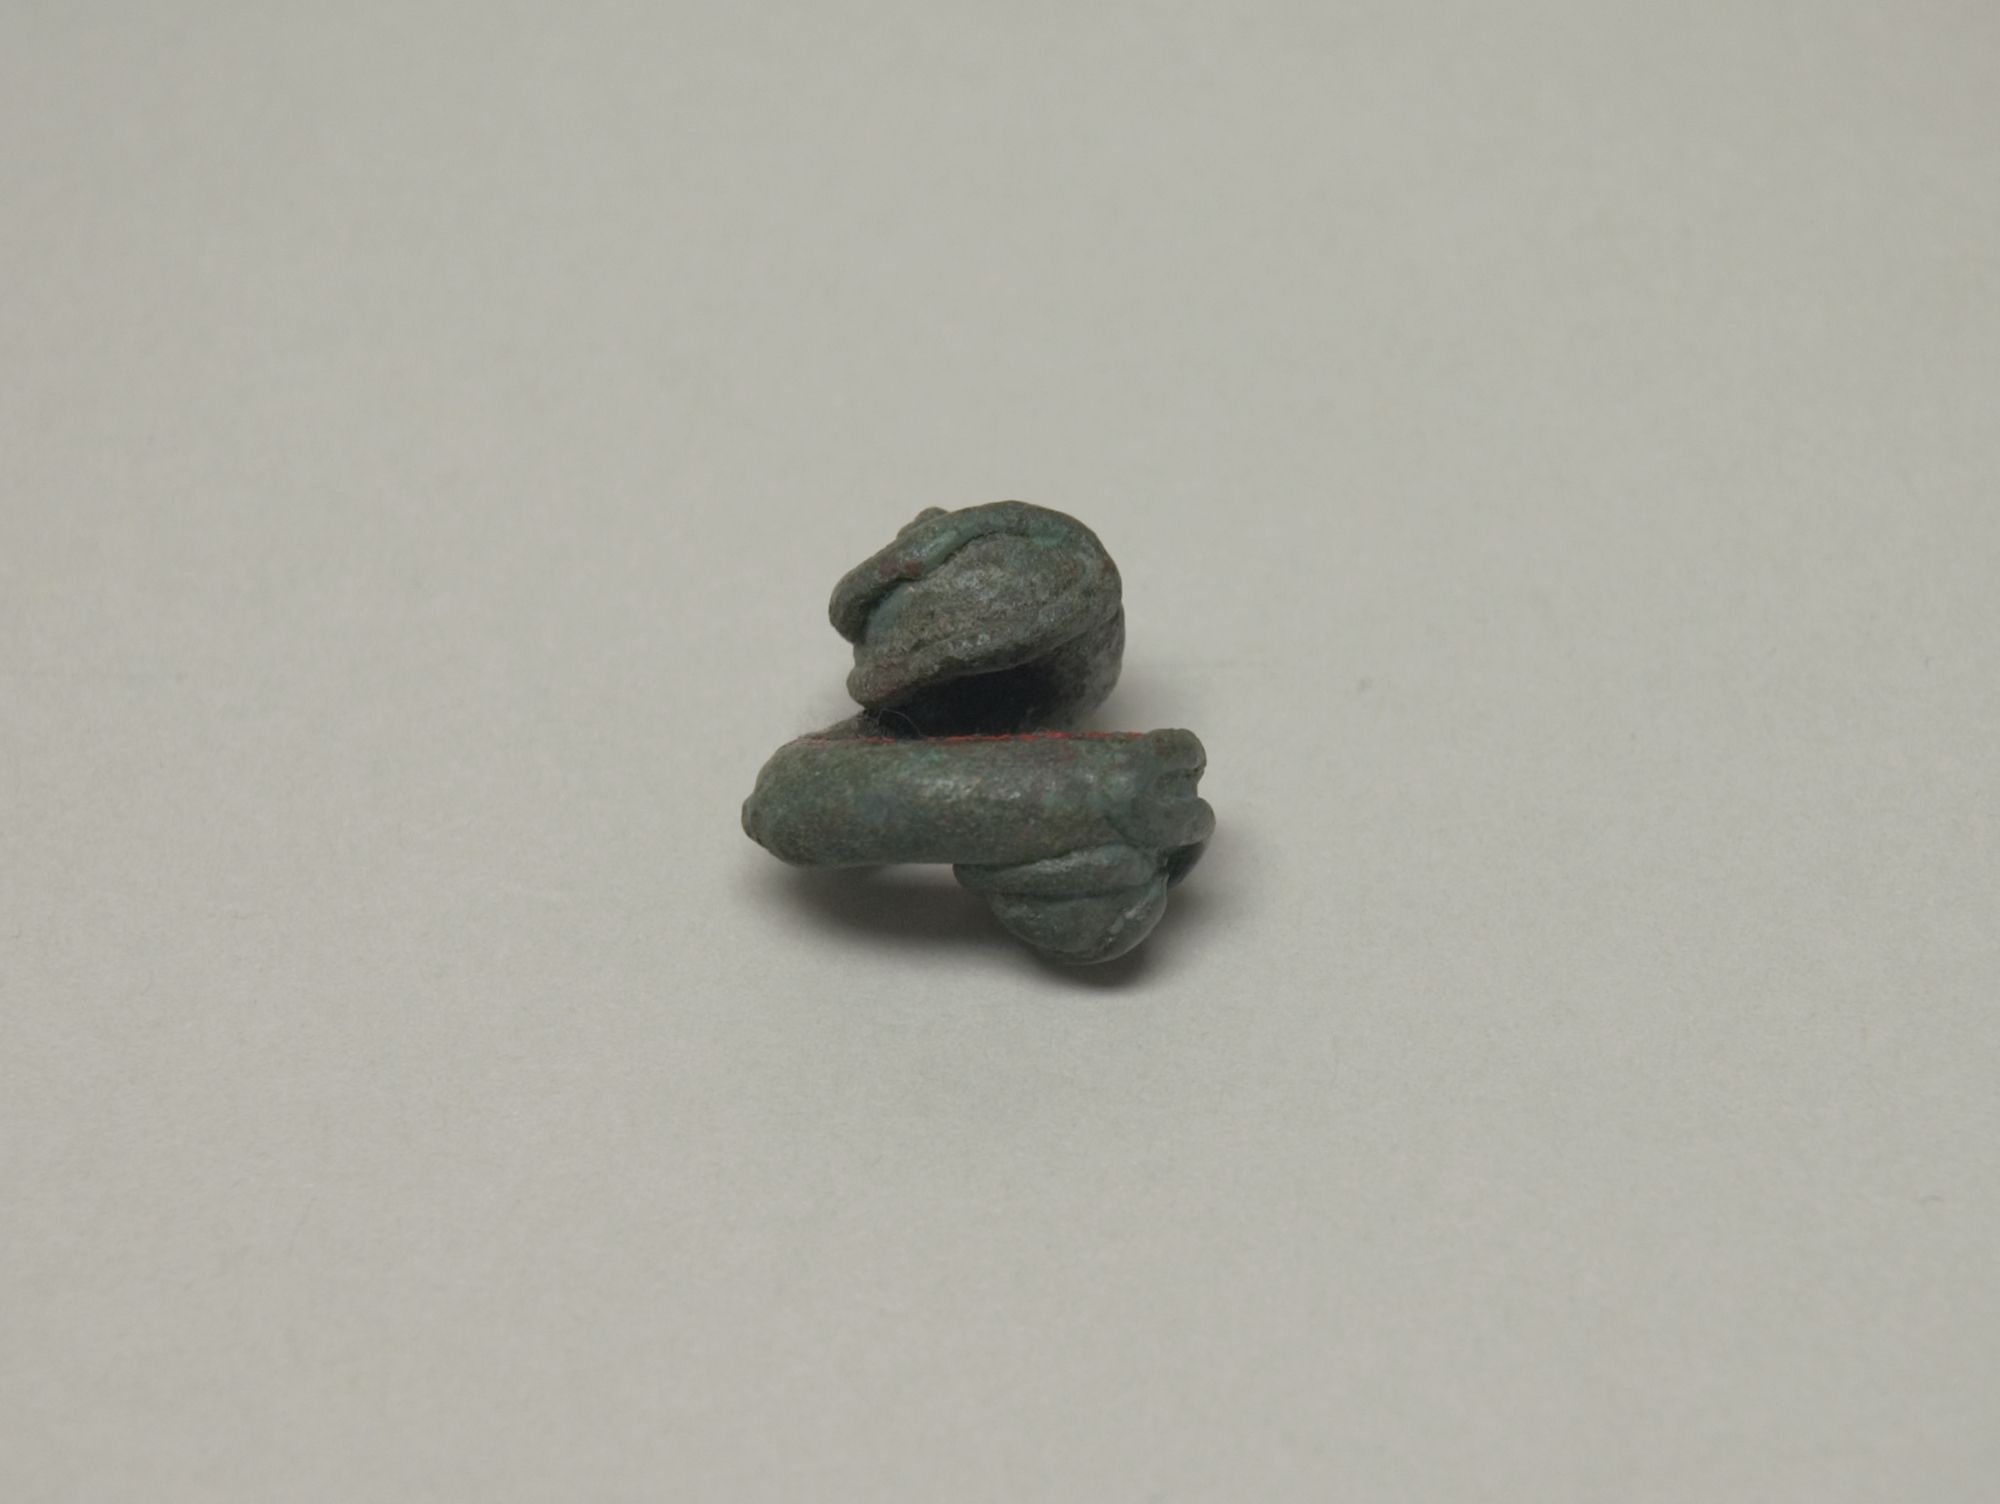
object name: earring with pendant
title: Ear pendant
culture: indonesian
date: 500 BCE-300 CE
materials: bronze